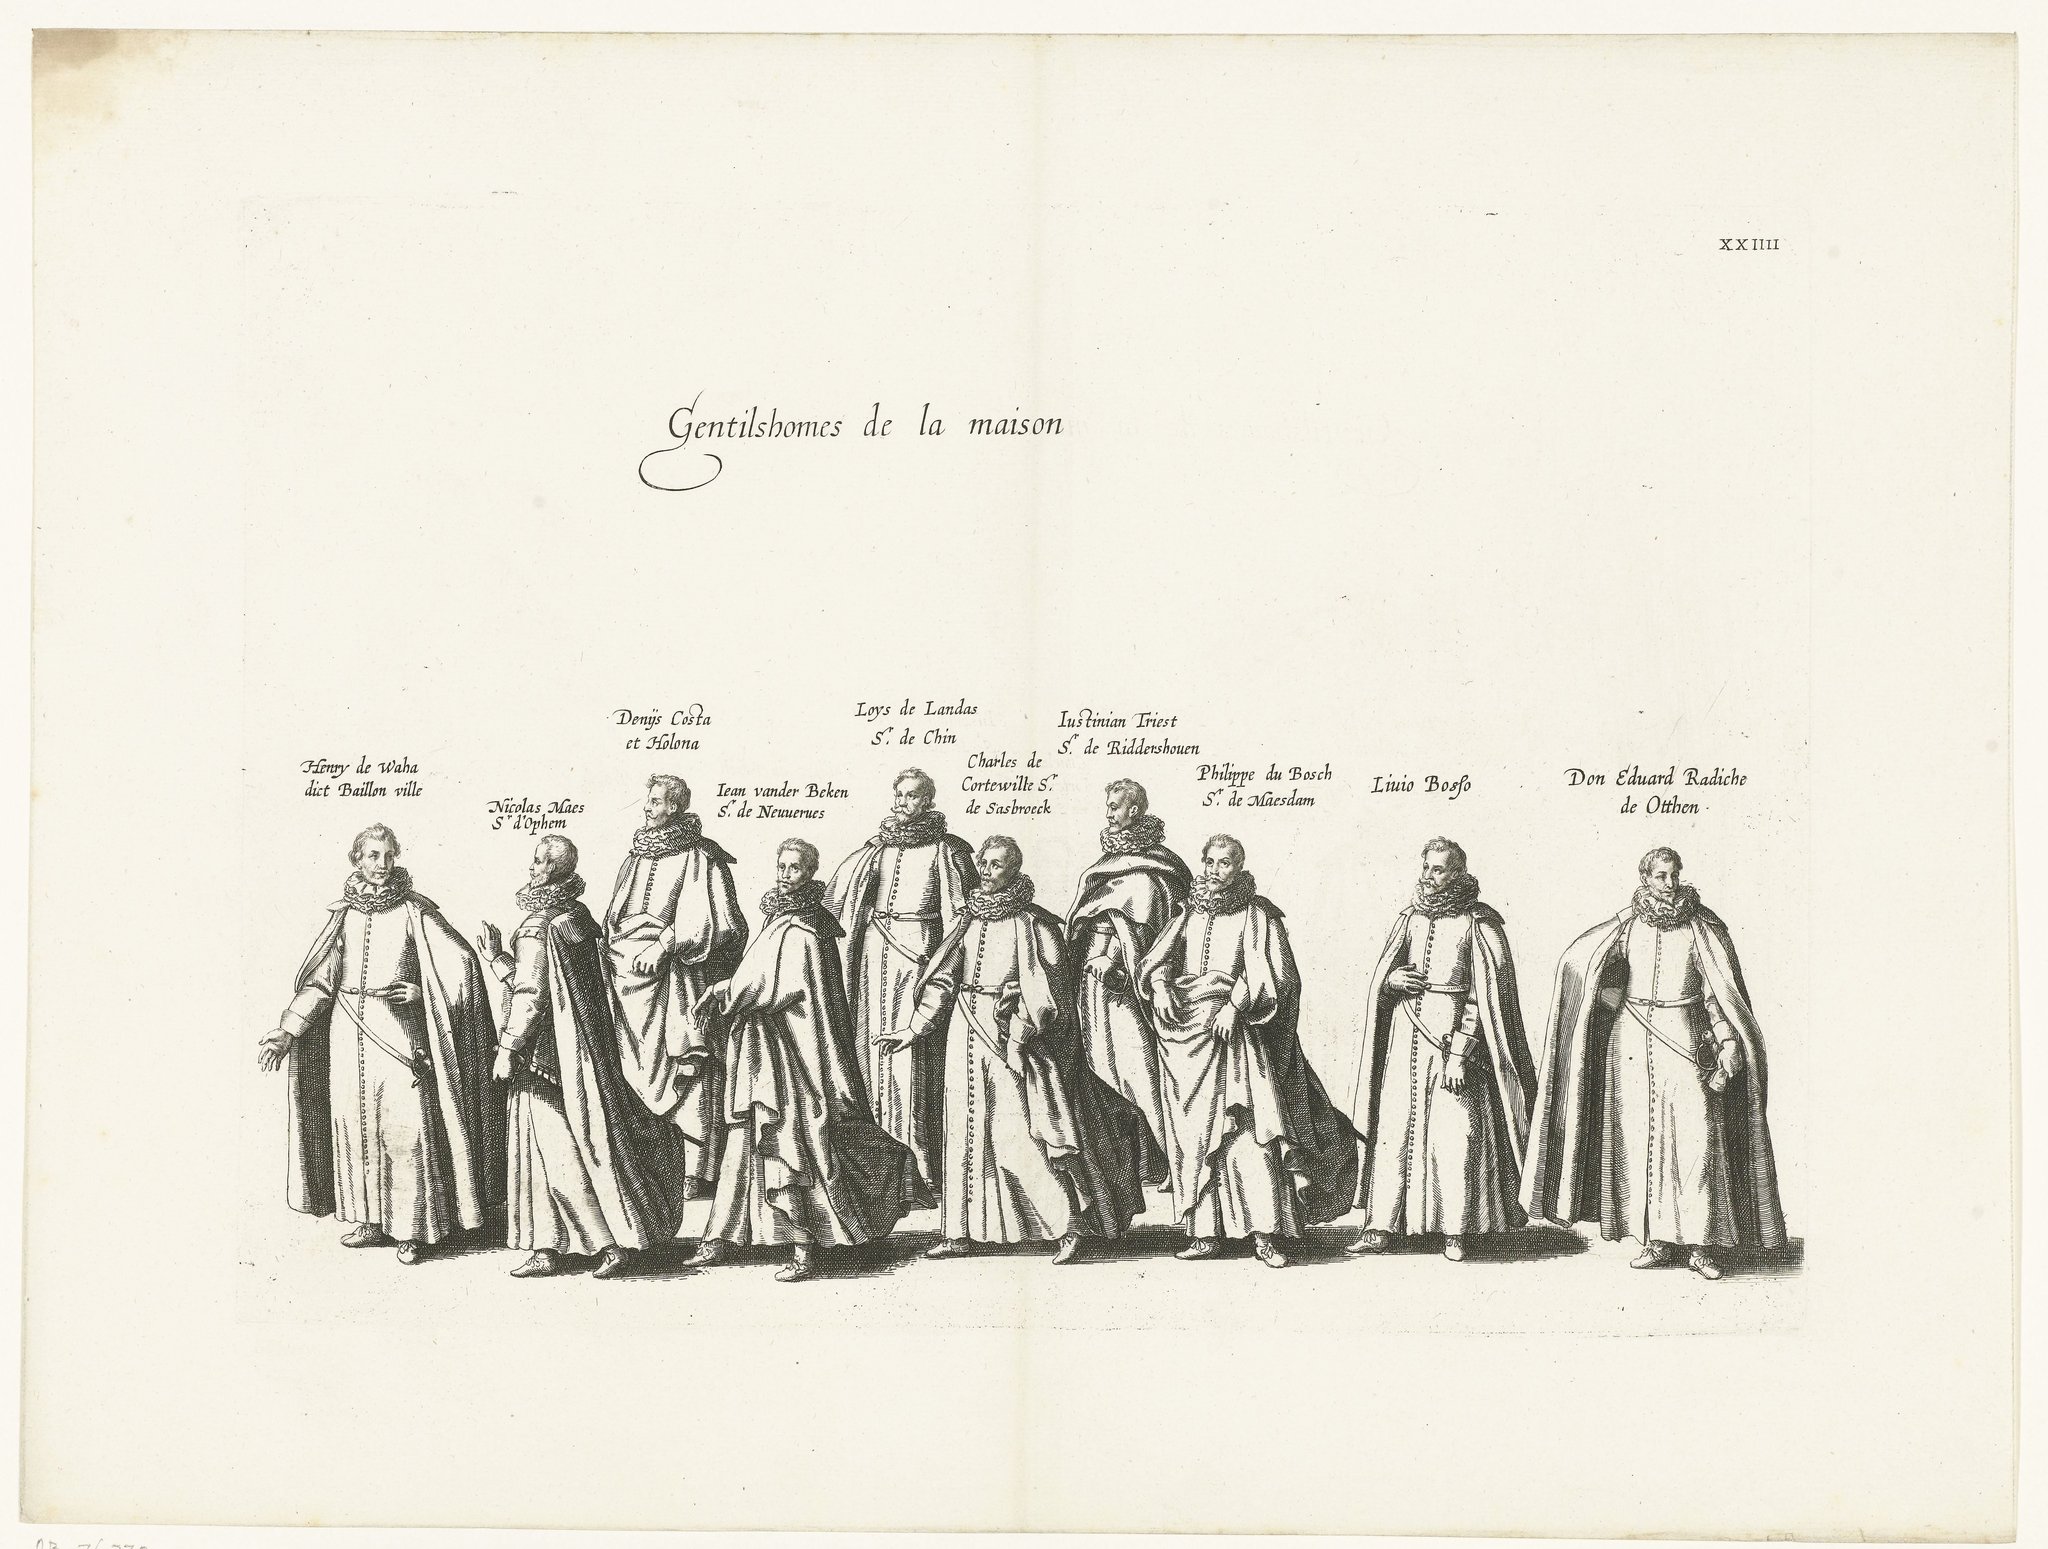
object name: print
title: Gentilshomes de la maison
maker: cornelis galle (i)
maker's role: print maker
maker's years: 1576-1650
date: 1623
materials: paper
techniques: etching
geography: southern netherlands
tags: brussels, albrecht aartshertog van oostenrijk, cortege, funeral procession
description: Deelnemers aan de begrafenisstoet. Plaat XXIIII in de serie van de begrafenis van aartshertog Albrecht van Oostenrijk te Brussel op 12 maart 1622.